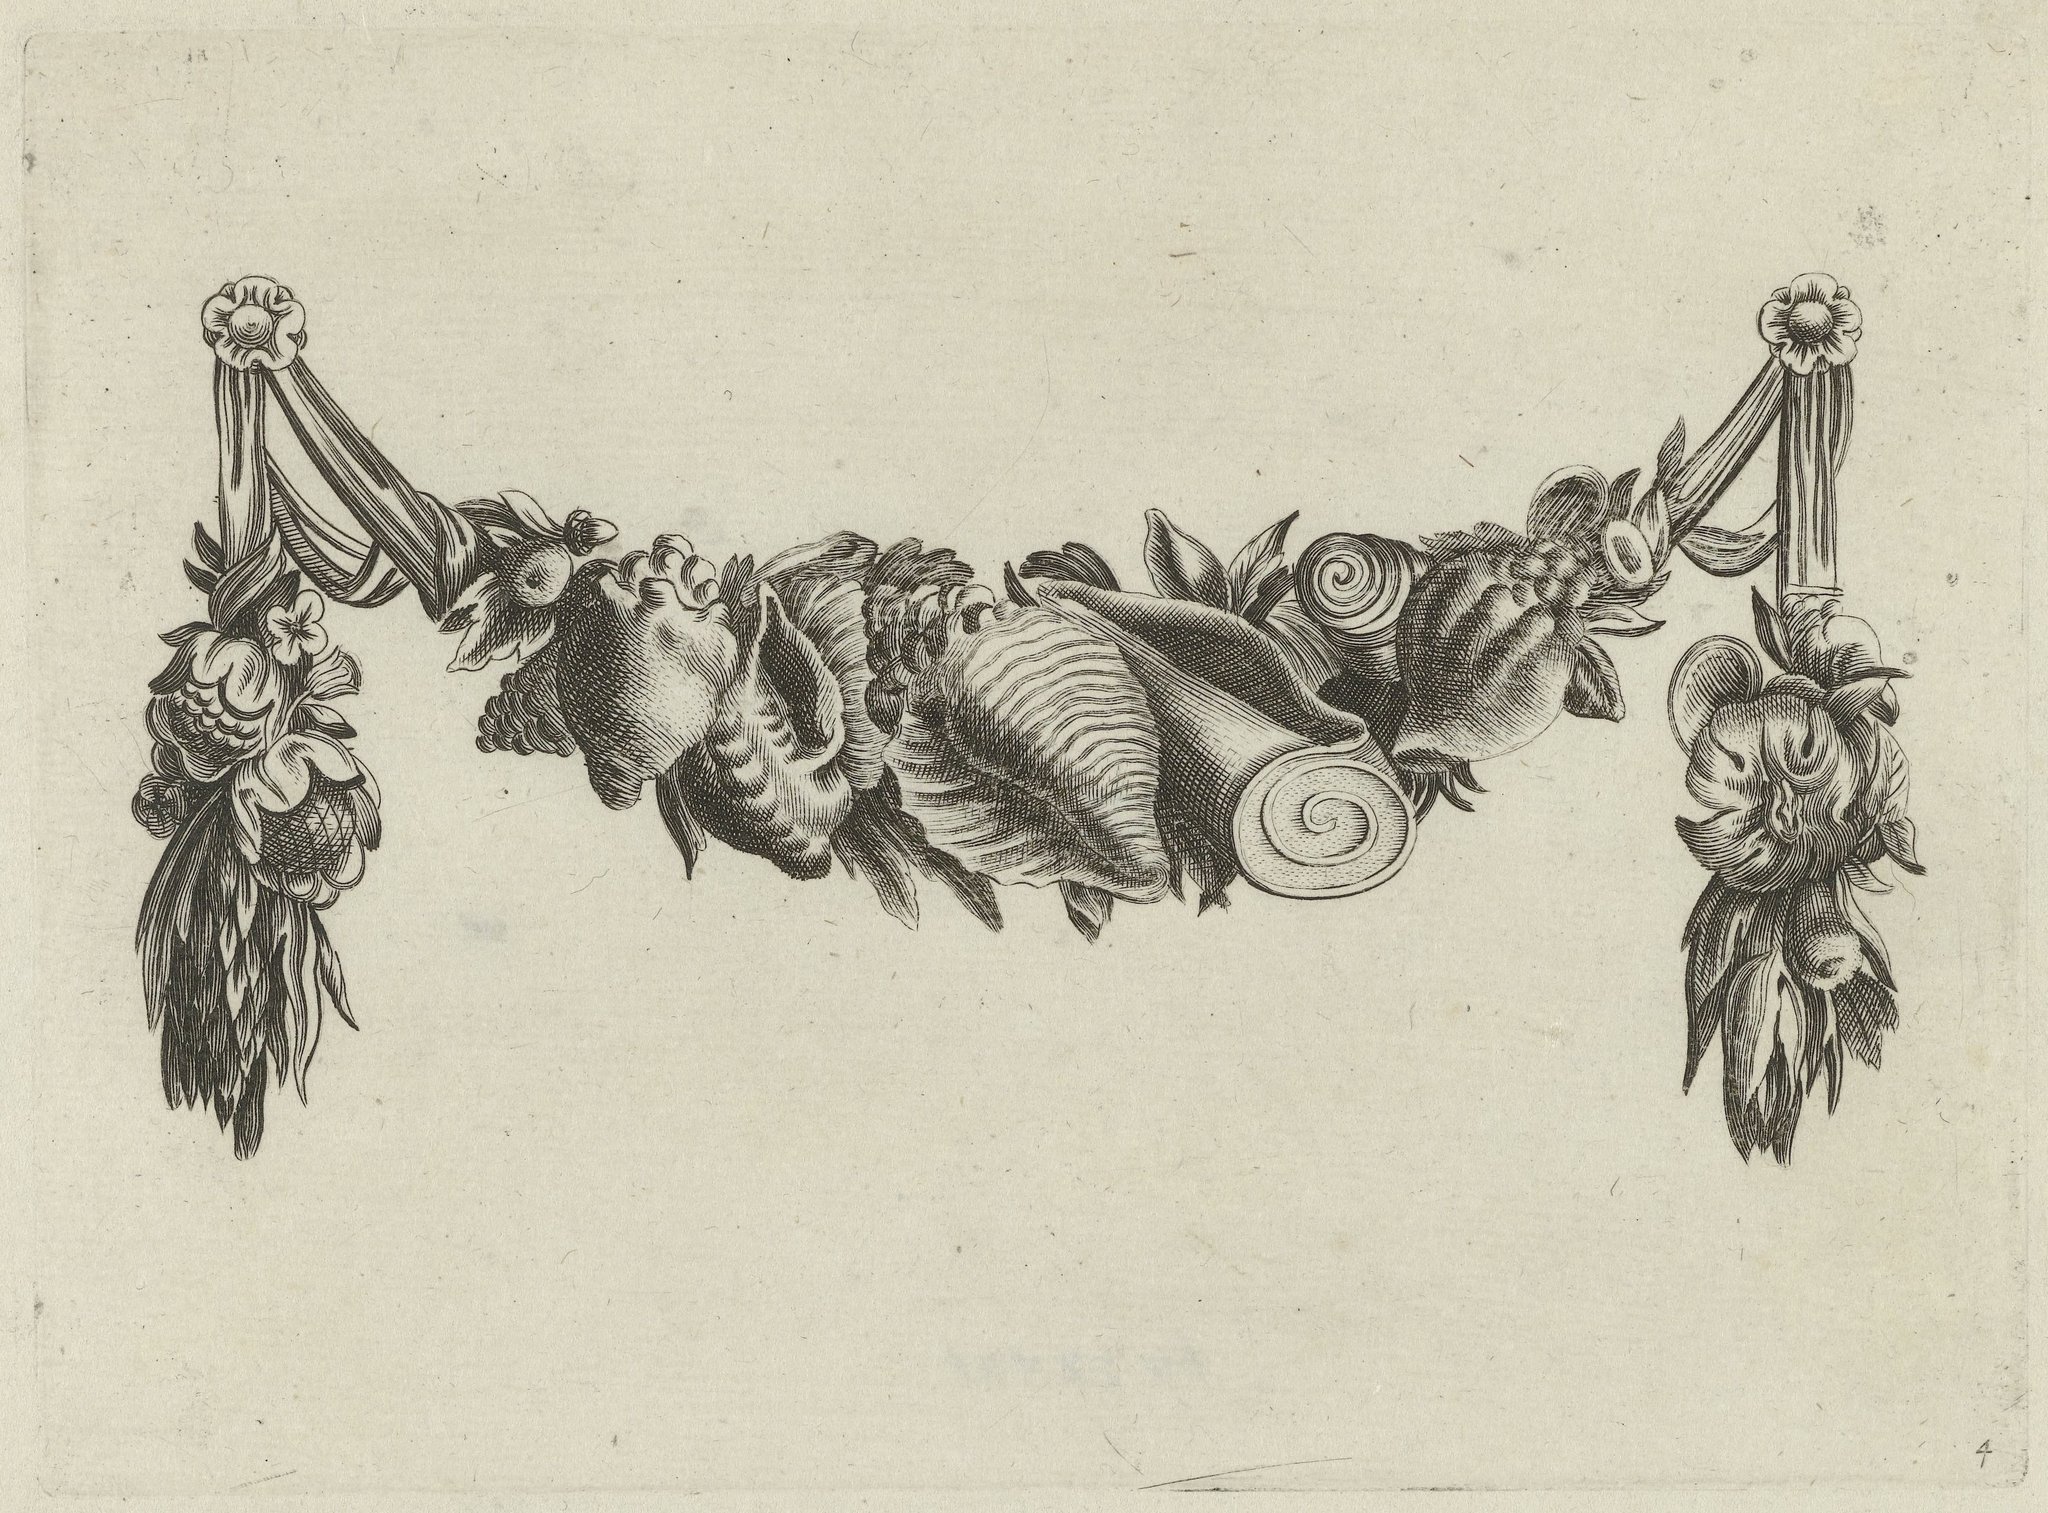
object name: ornament print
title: Verscheide Nieuwe Festonnen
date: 1655-1678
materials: paper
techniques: engraving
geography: amsterdam